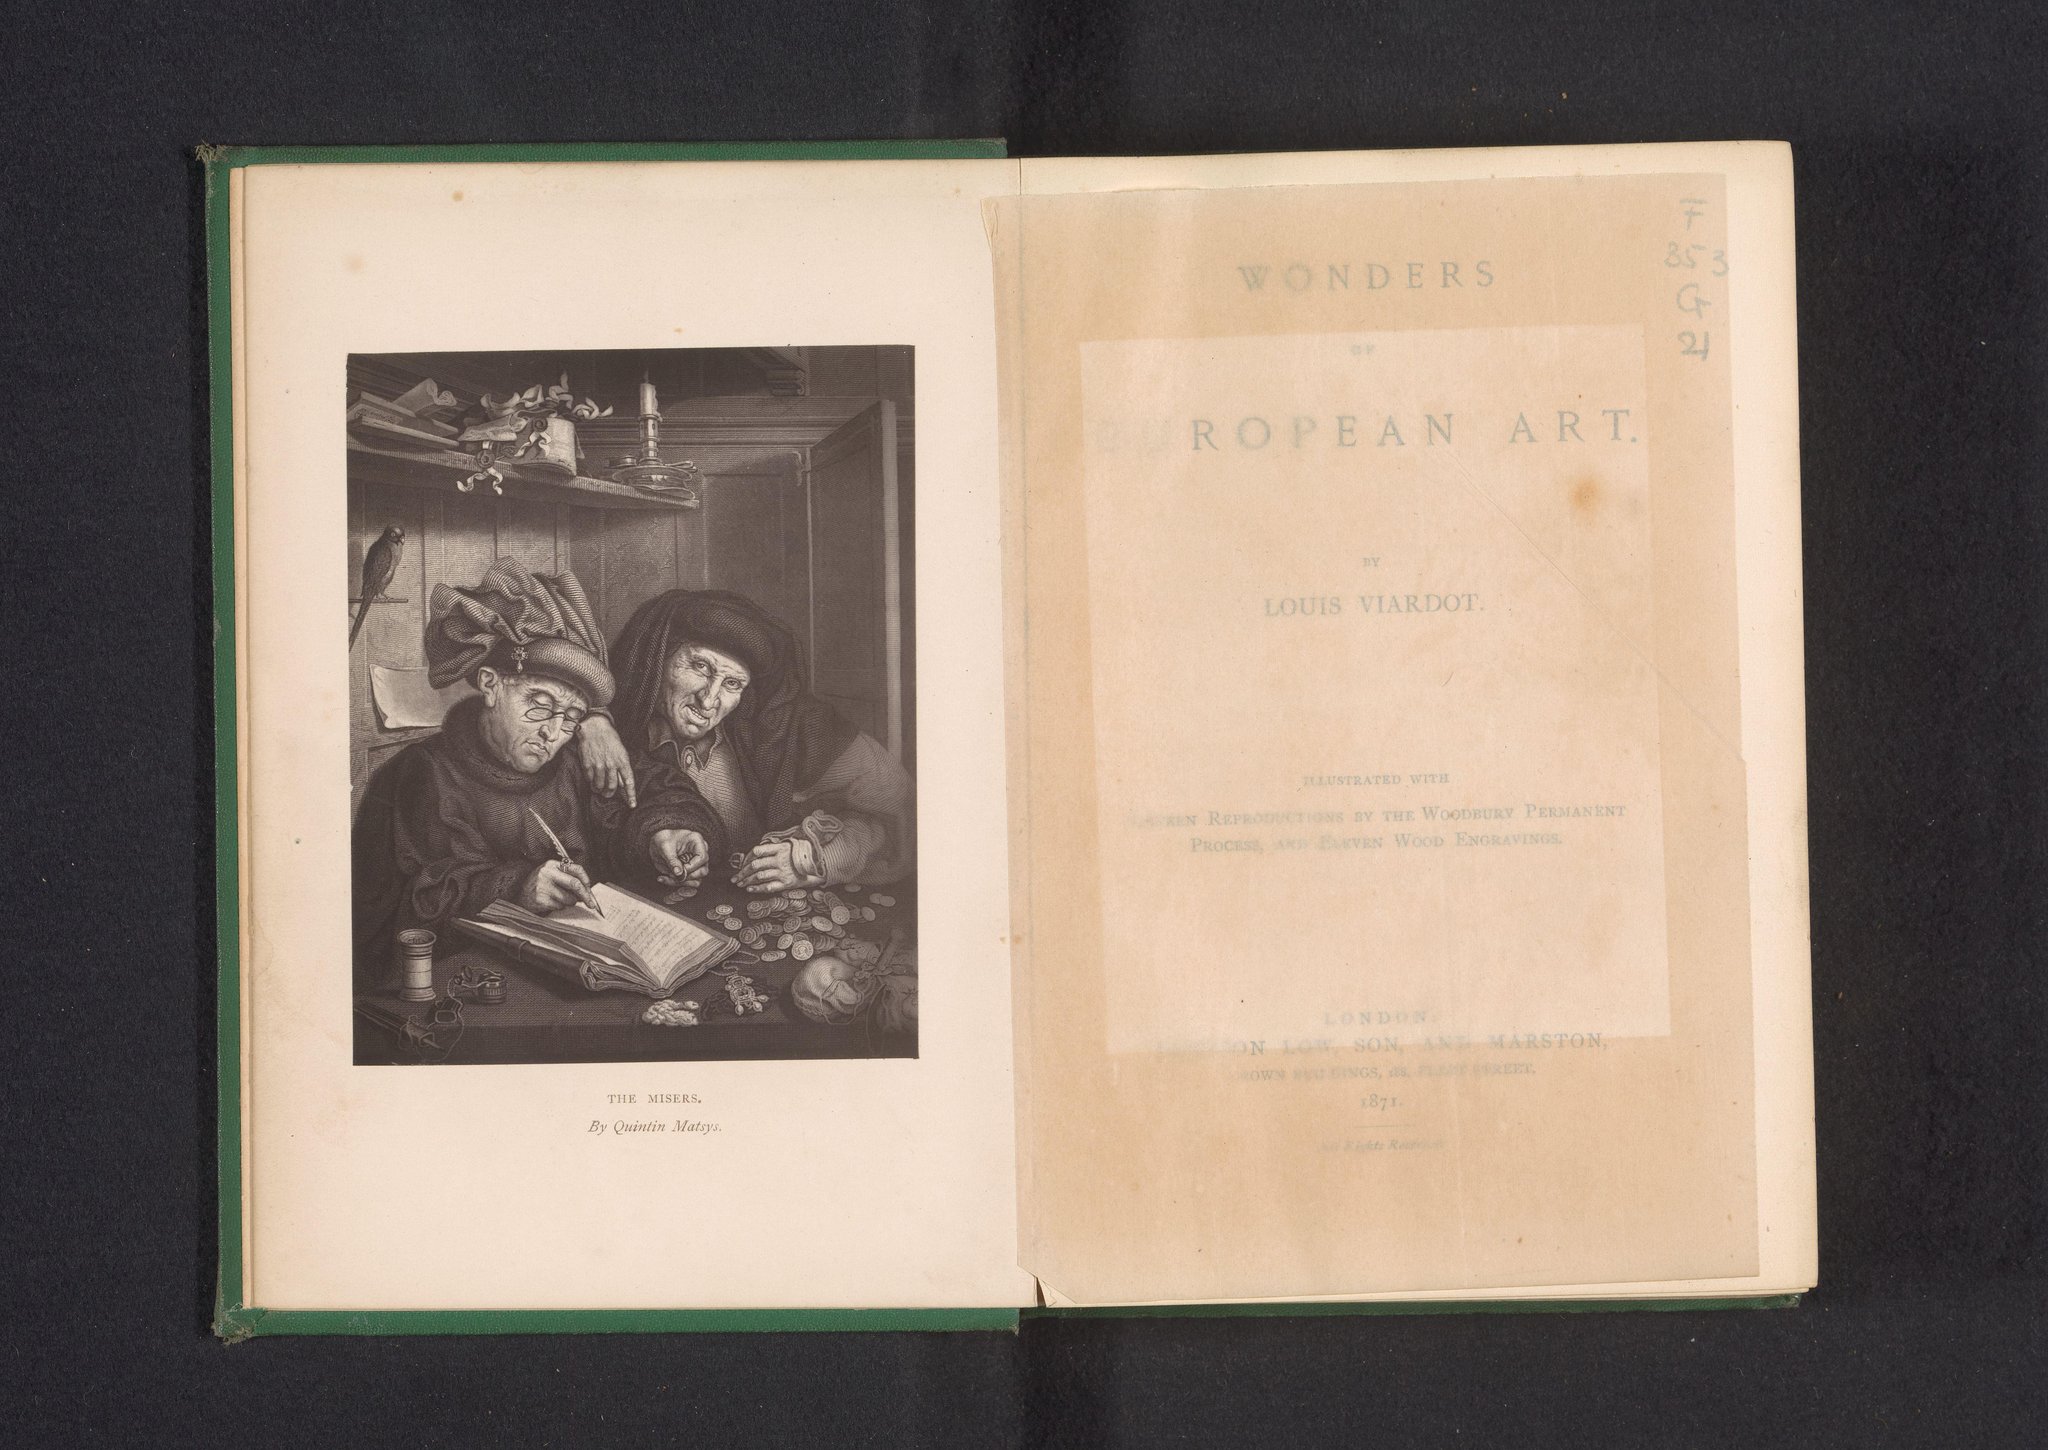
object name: photomechanical print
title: Fotoreproductie van een prent naar het schilderij De geldtellers door Quinten Massijs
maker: Anonymous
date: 1861-1871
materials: paper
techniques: woodburytype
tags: miser